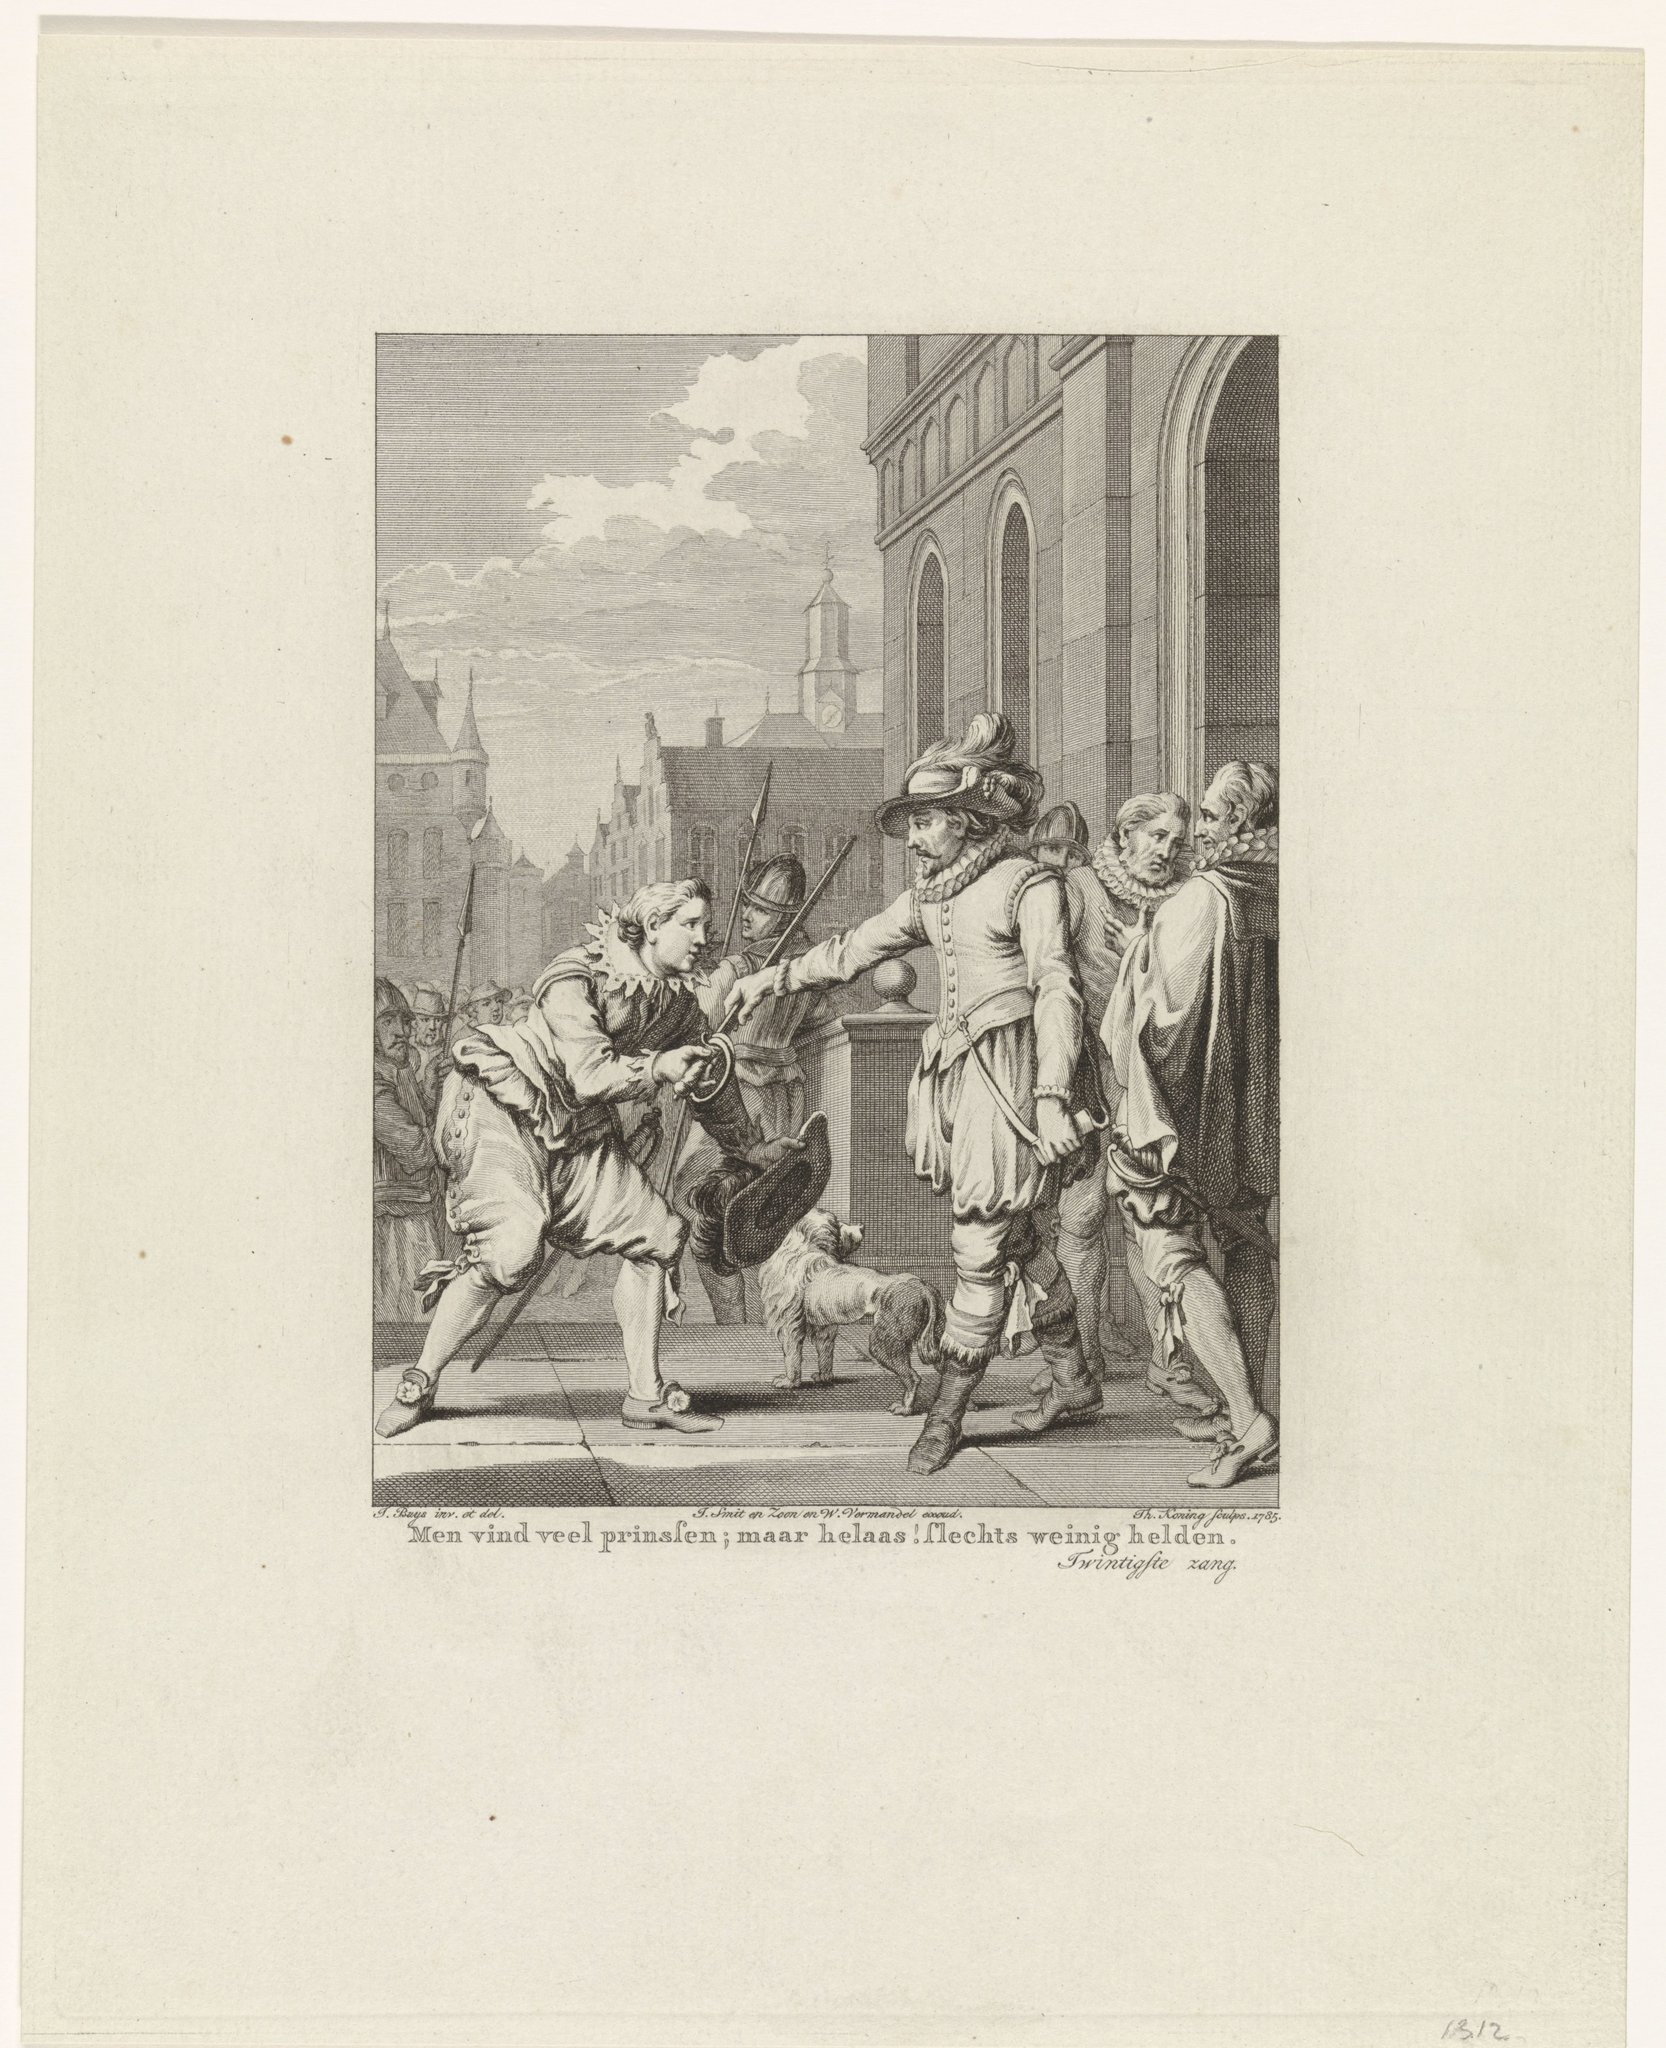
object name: history print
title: Taferelen uit het leven van prins Willem I, 1568-1584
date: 1785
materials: paper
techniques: engraving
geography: amsterdam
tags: delft, william i (prince of orange)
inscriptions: collector's mark: Lugt 2228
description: Goignies, vrijgelaten op verzoek van Mondragon, ontvangt van Oranje een degen, 1578. Deze prent maakt deel uit van een serie van 24 prenten met taferelen uit het leven van prins Willem I, 1568-1584 en is een illustratie bij de twintigste zang.